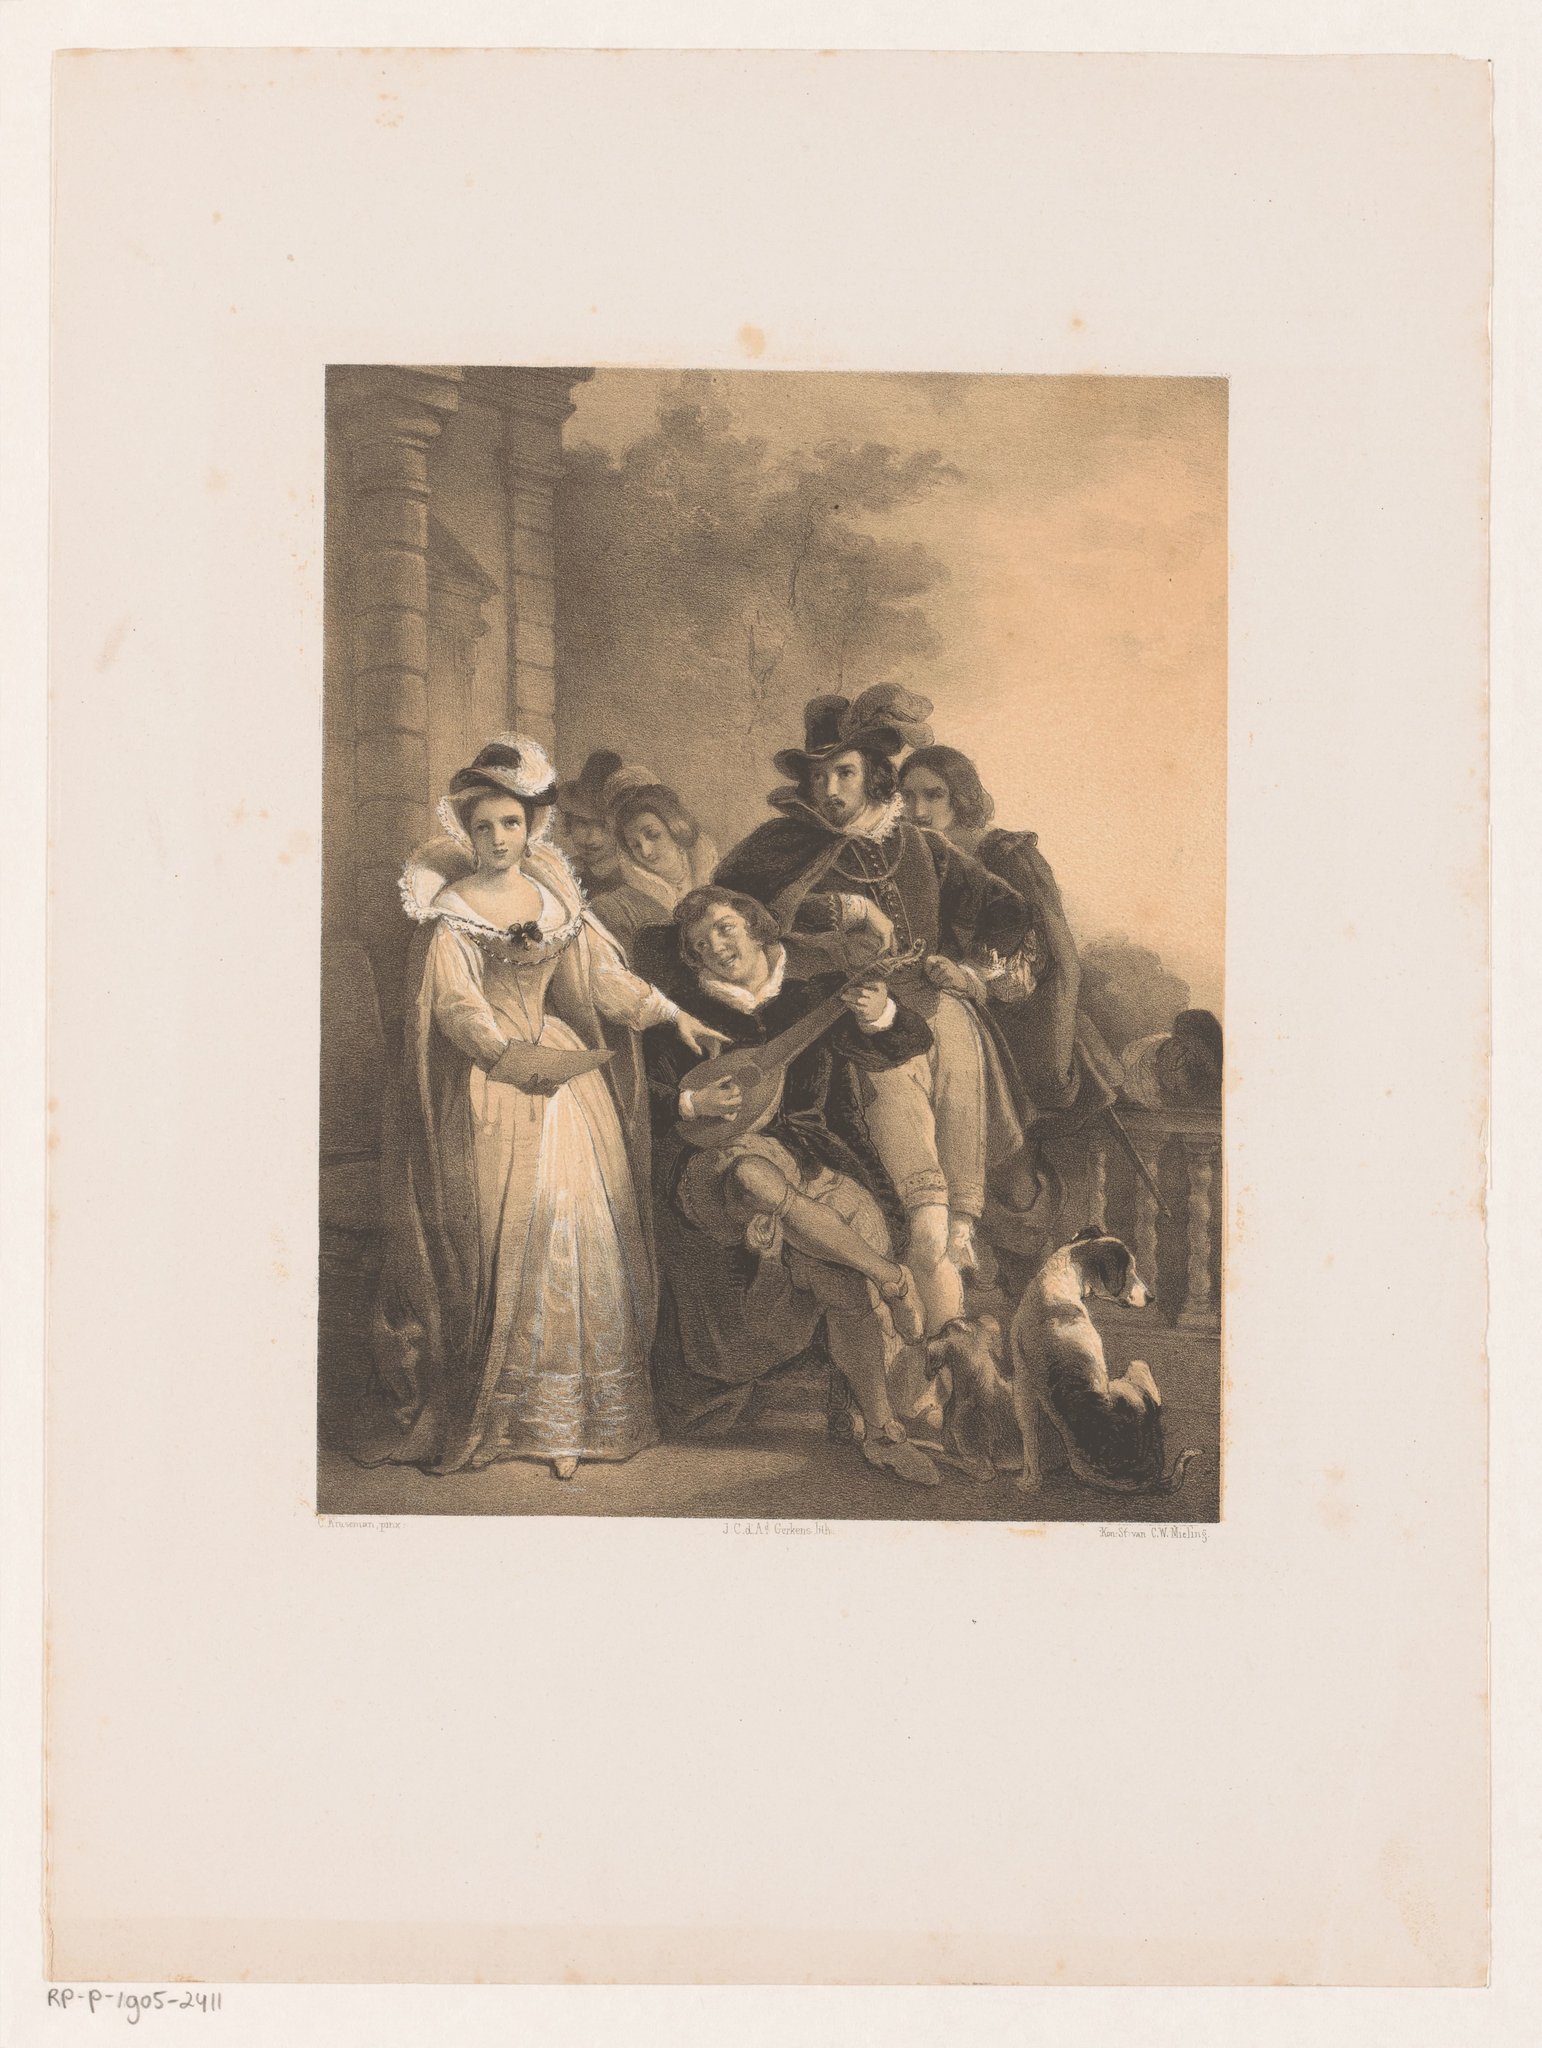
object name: print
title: Gezelschap met luitspeler en zangeres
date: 1847-1863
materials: paper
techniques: tone lithography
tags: musician(s) accompanying singer(s), one person playing string instrument (plucked), cithern, mandolin, guitar, balalaika, dog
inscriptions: collector's mark: Lugt 2228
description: De luitspeler zit op een stoel en kijkt naar de zingende vrouw naast hem. Achter hen staat een groepje mannen en een vrouw. Op de grond zitten twee honden.